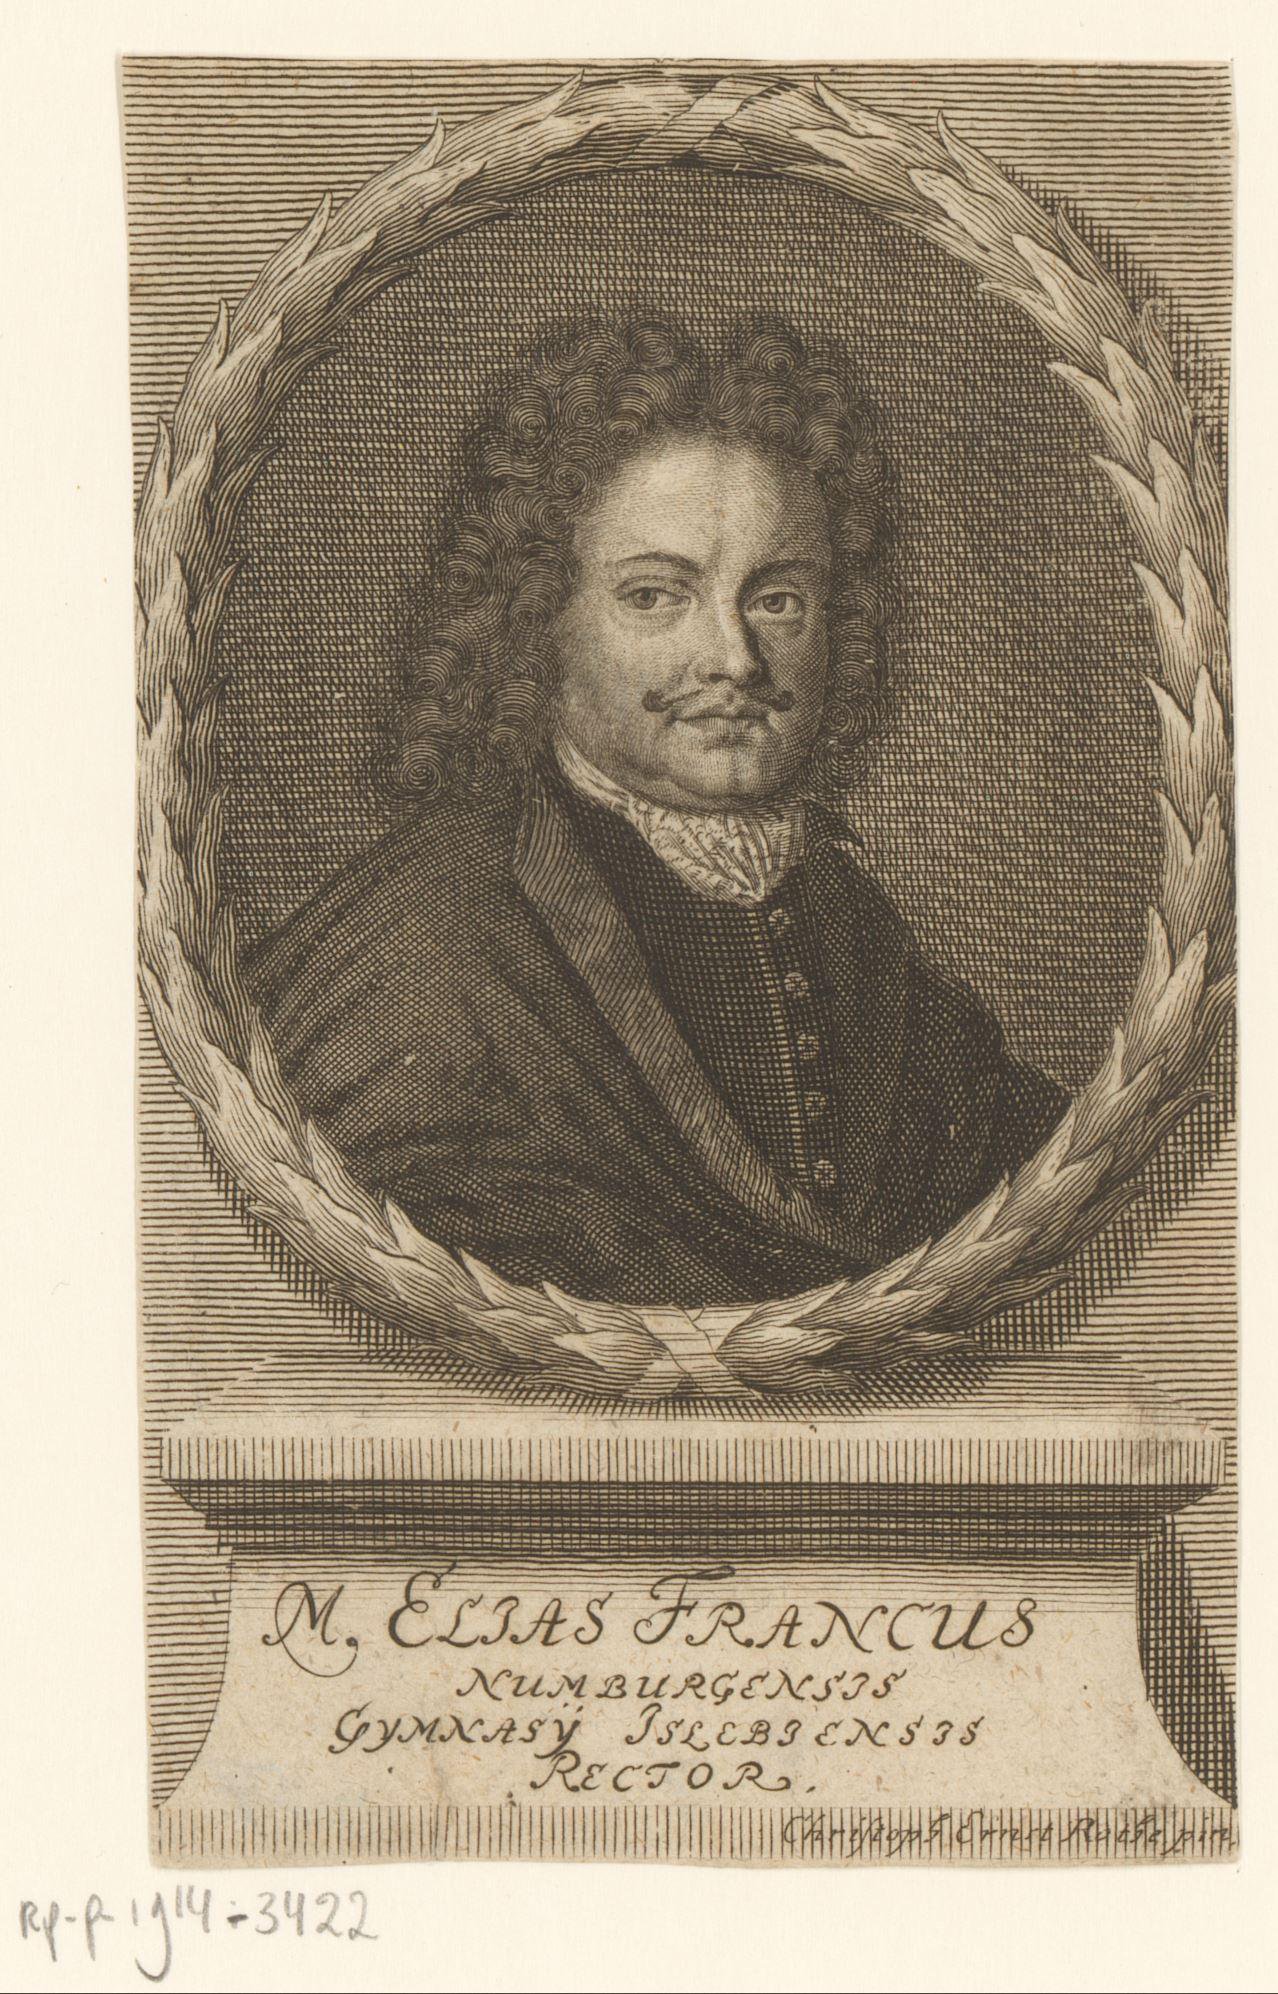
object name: print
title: Portret van Elias Franck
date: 1665-1721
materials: paper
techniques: engraving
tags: historical persons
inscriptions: collector's mark: Lugt 2228